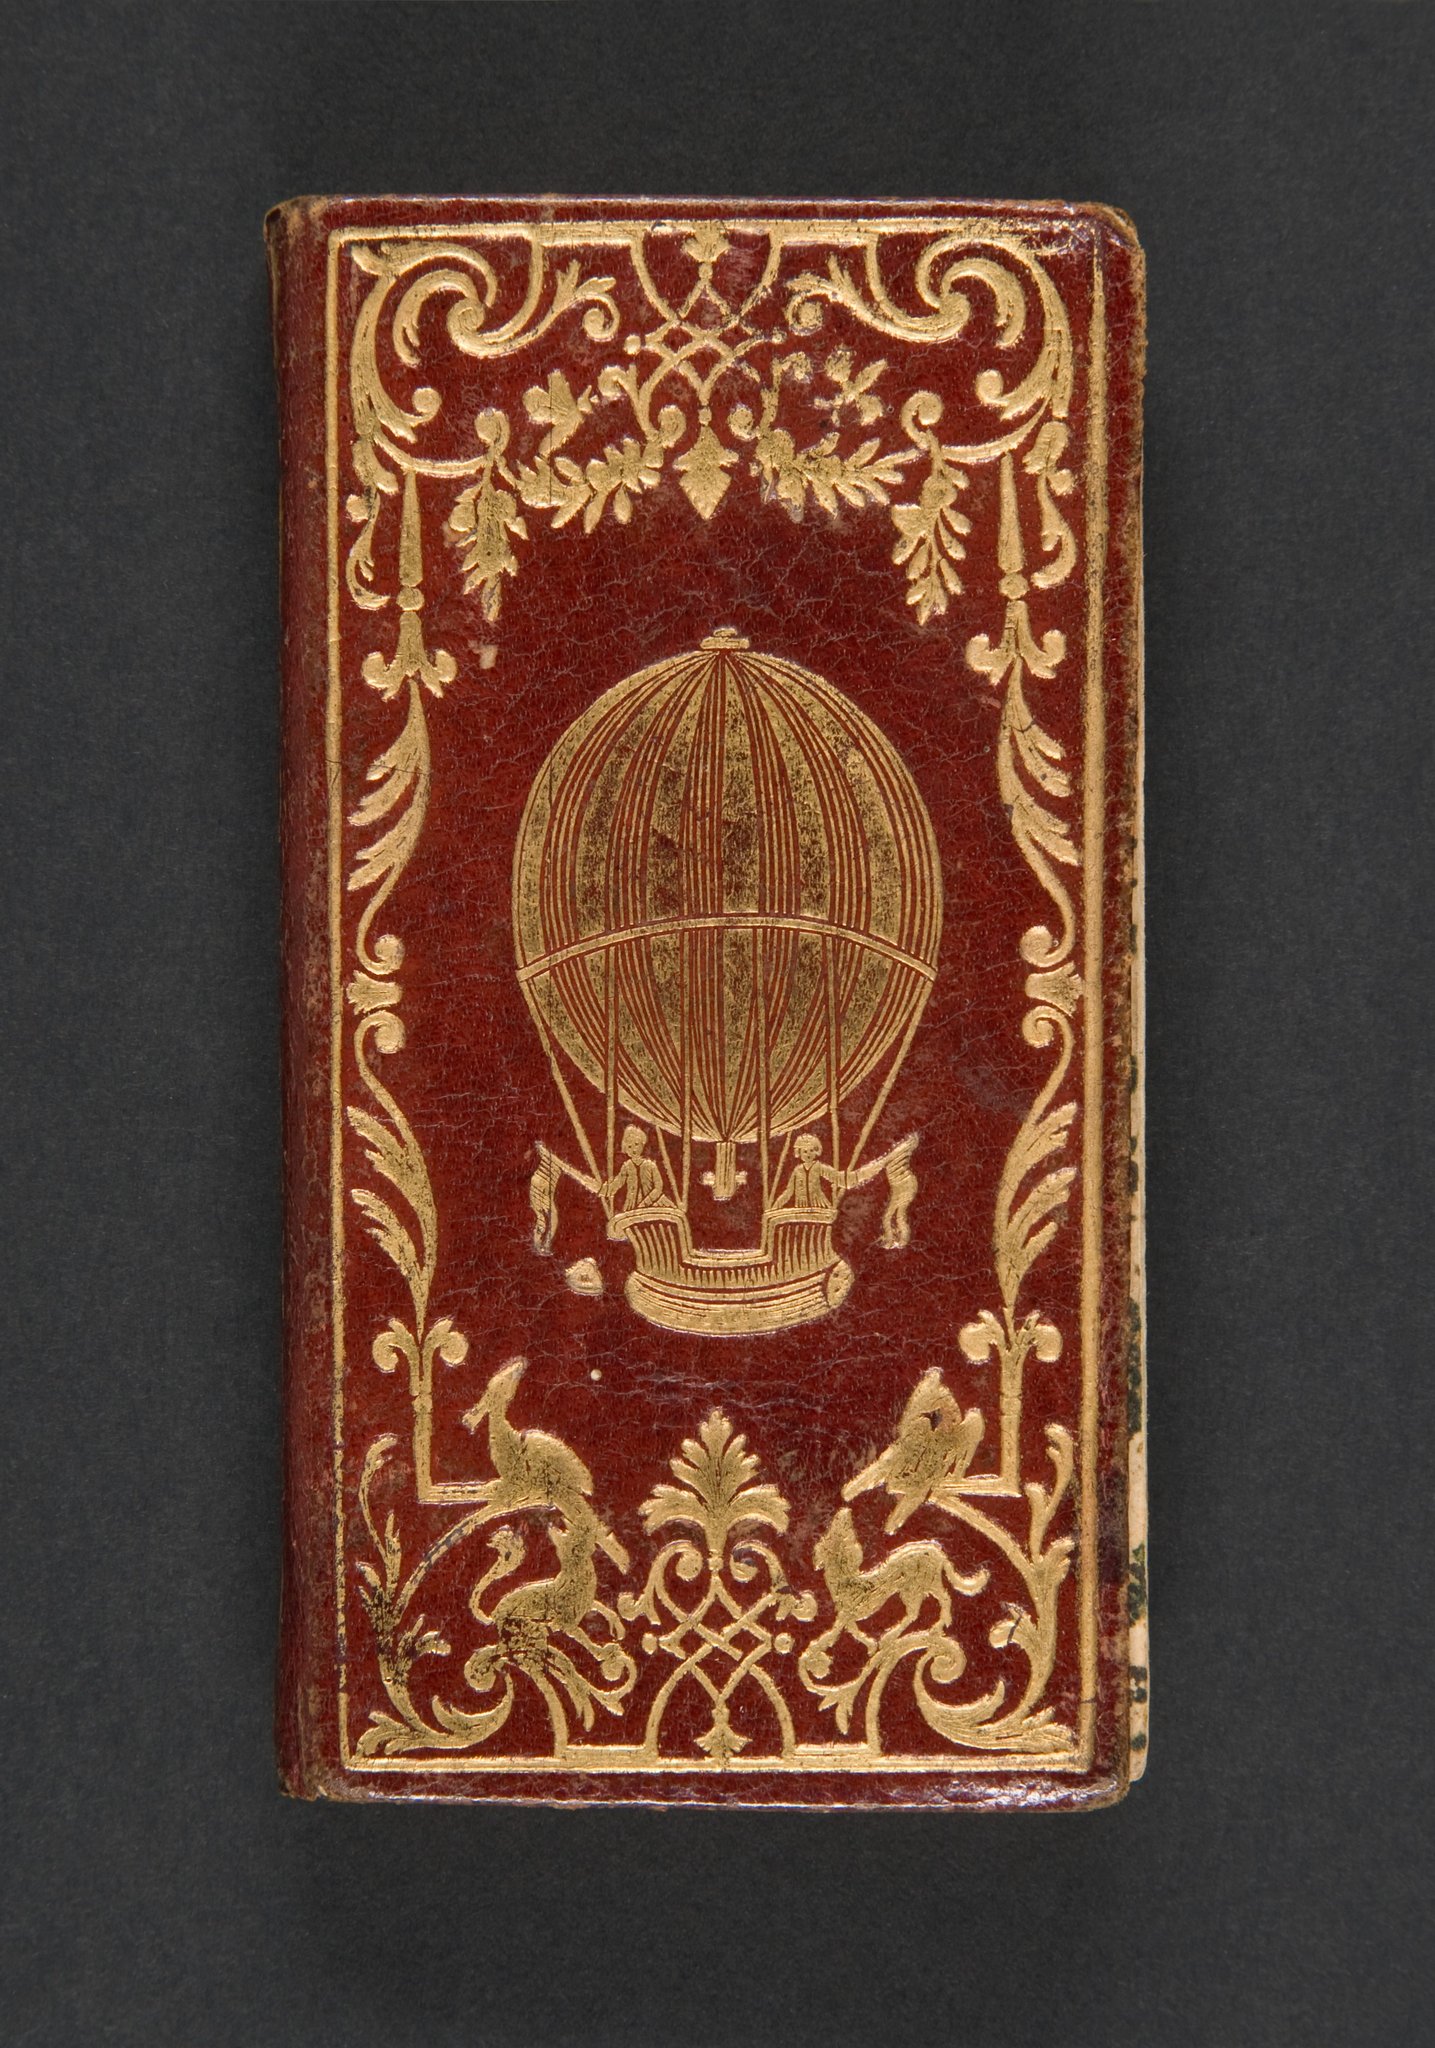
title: Le calendrier de la cour : tiré des ephémérides, pour l'année bissextile mil sept-cent quatre-vingt-quatre : contenant le lieu du soleil, son lever, son coucher, sa déclinaison: le lever de la lune & son coucher, &c. : avec la naissance des rois, reines, princes & princesses de l'Europe imprimé pour la famille royale et maison de sa Majesté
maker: la veuve hérissant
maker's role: printer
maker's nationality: french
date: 1784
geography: france